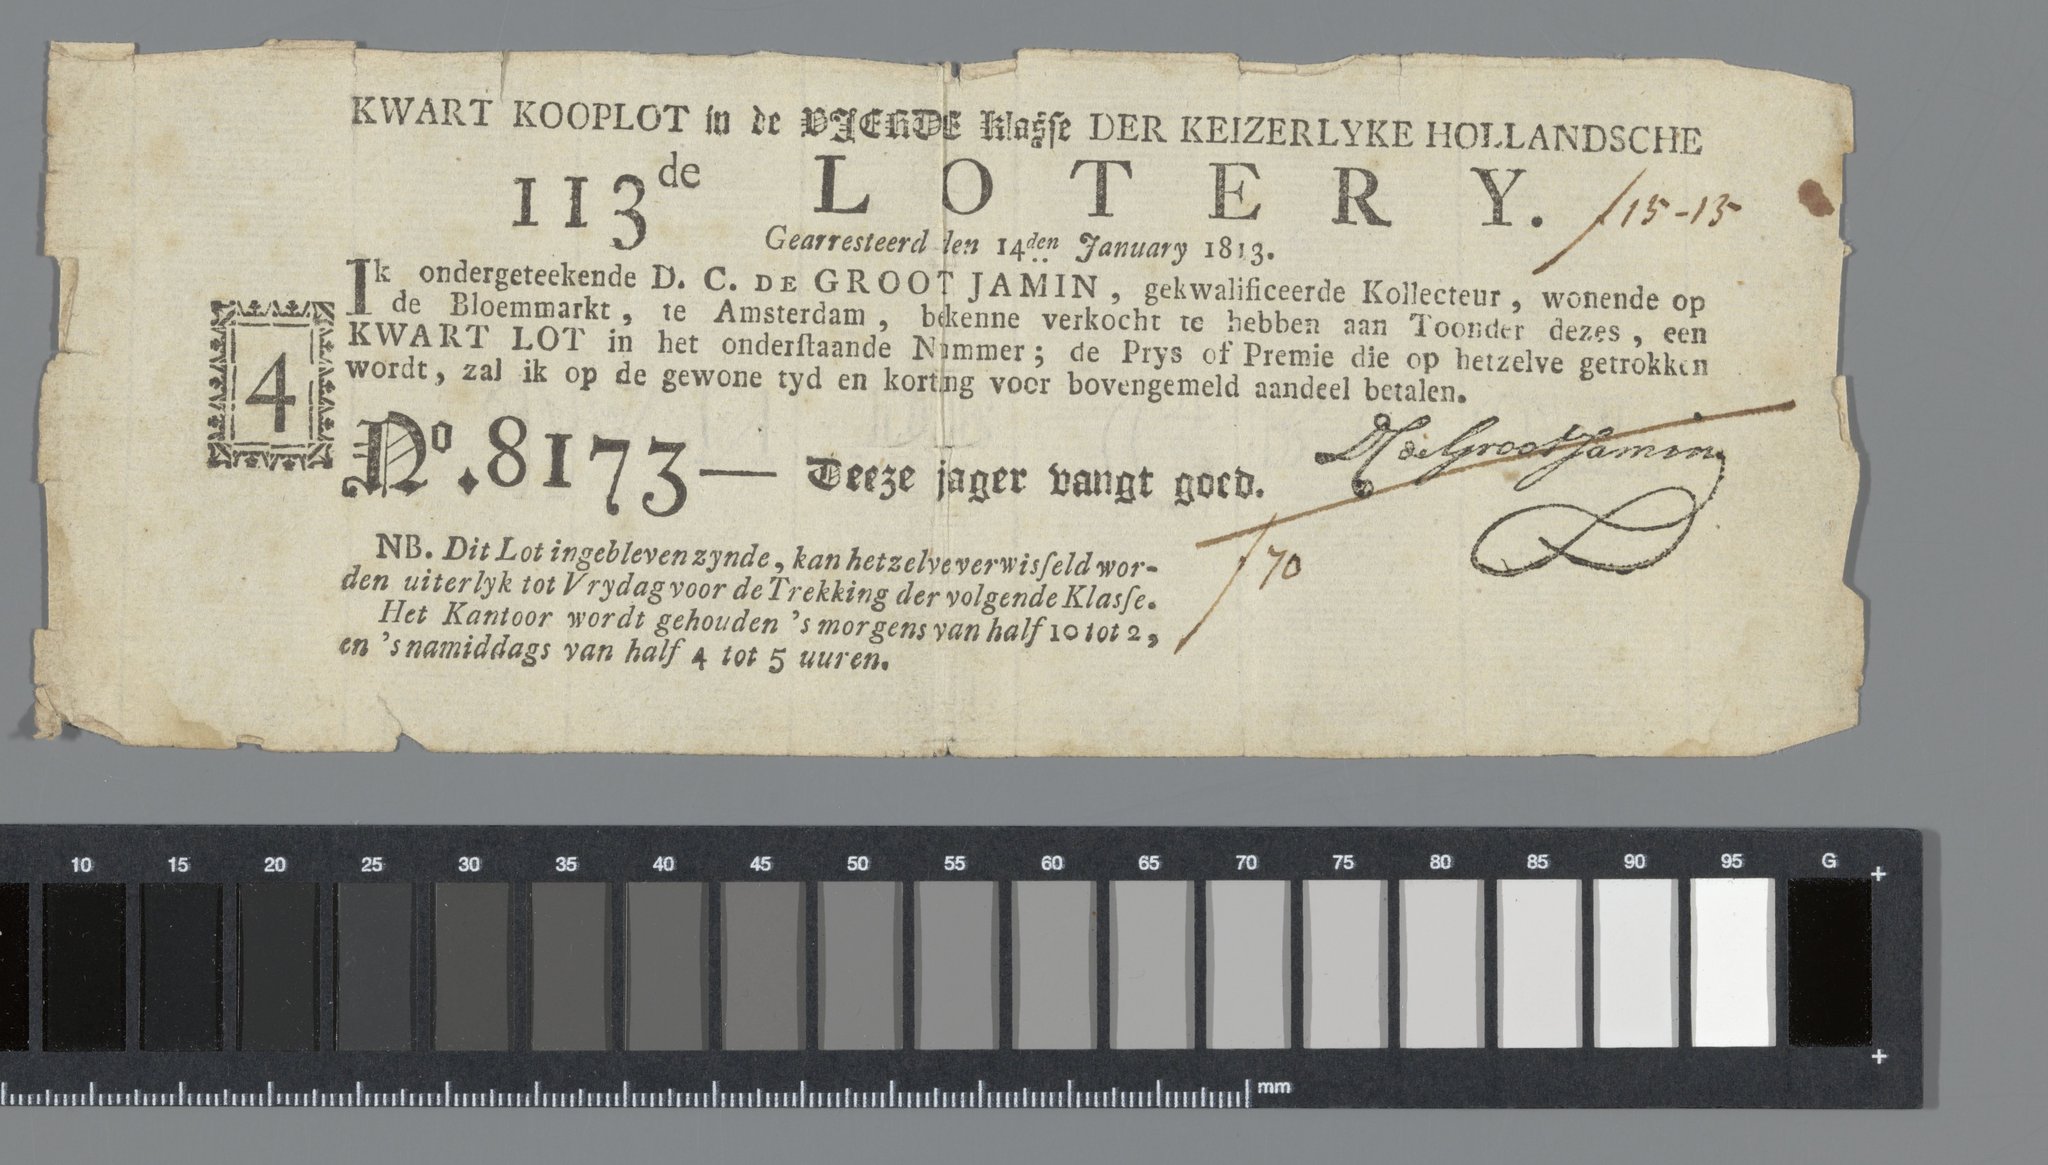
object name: loterijbrief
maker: j.g. de groot jamin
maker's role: schrijver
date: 1813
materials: paper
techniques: printing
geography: amsterdam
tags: netherlands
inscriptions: date